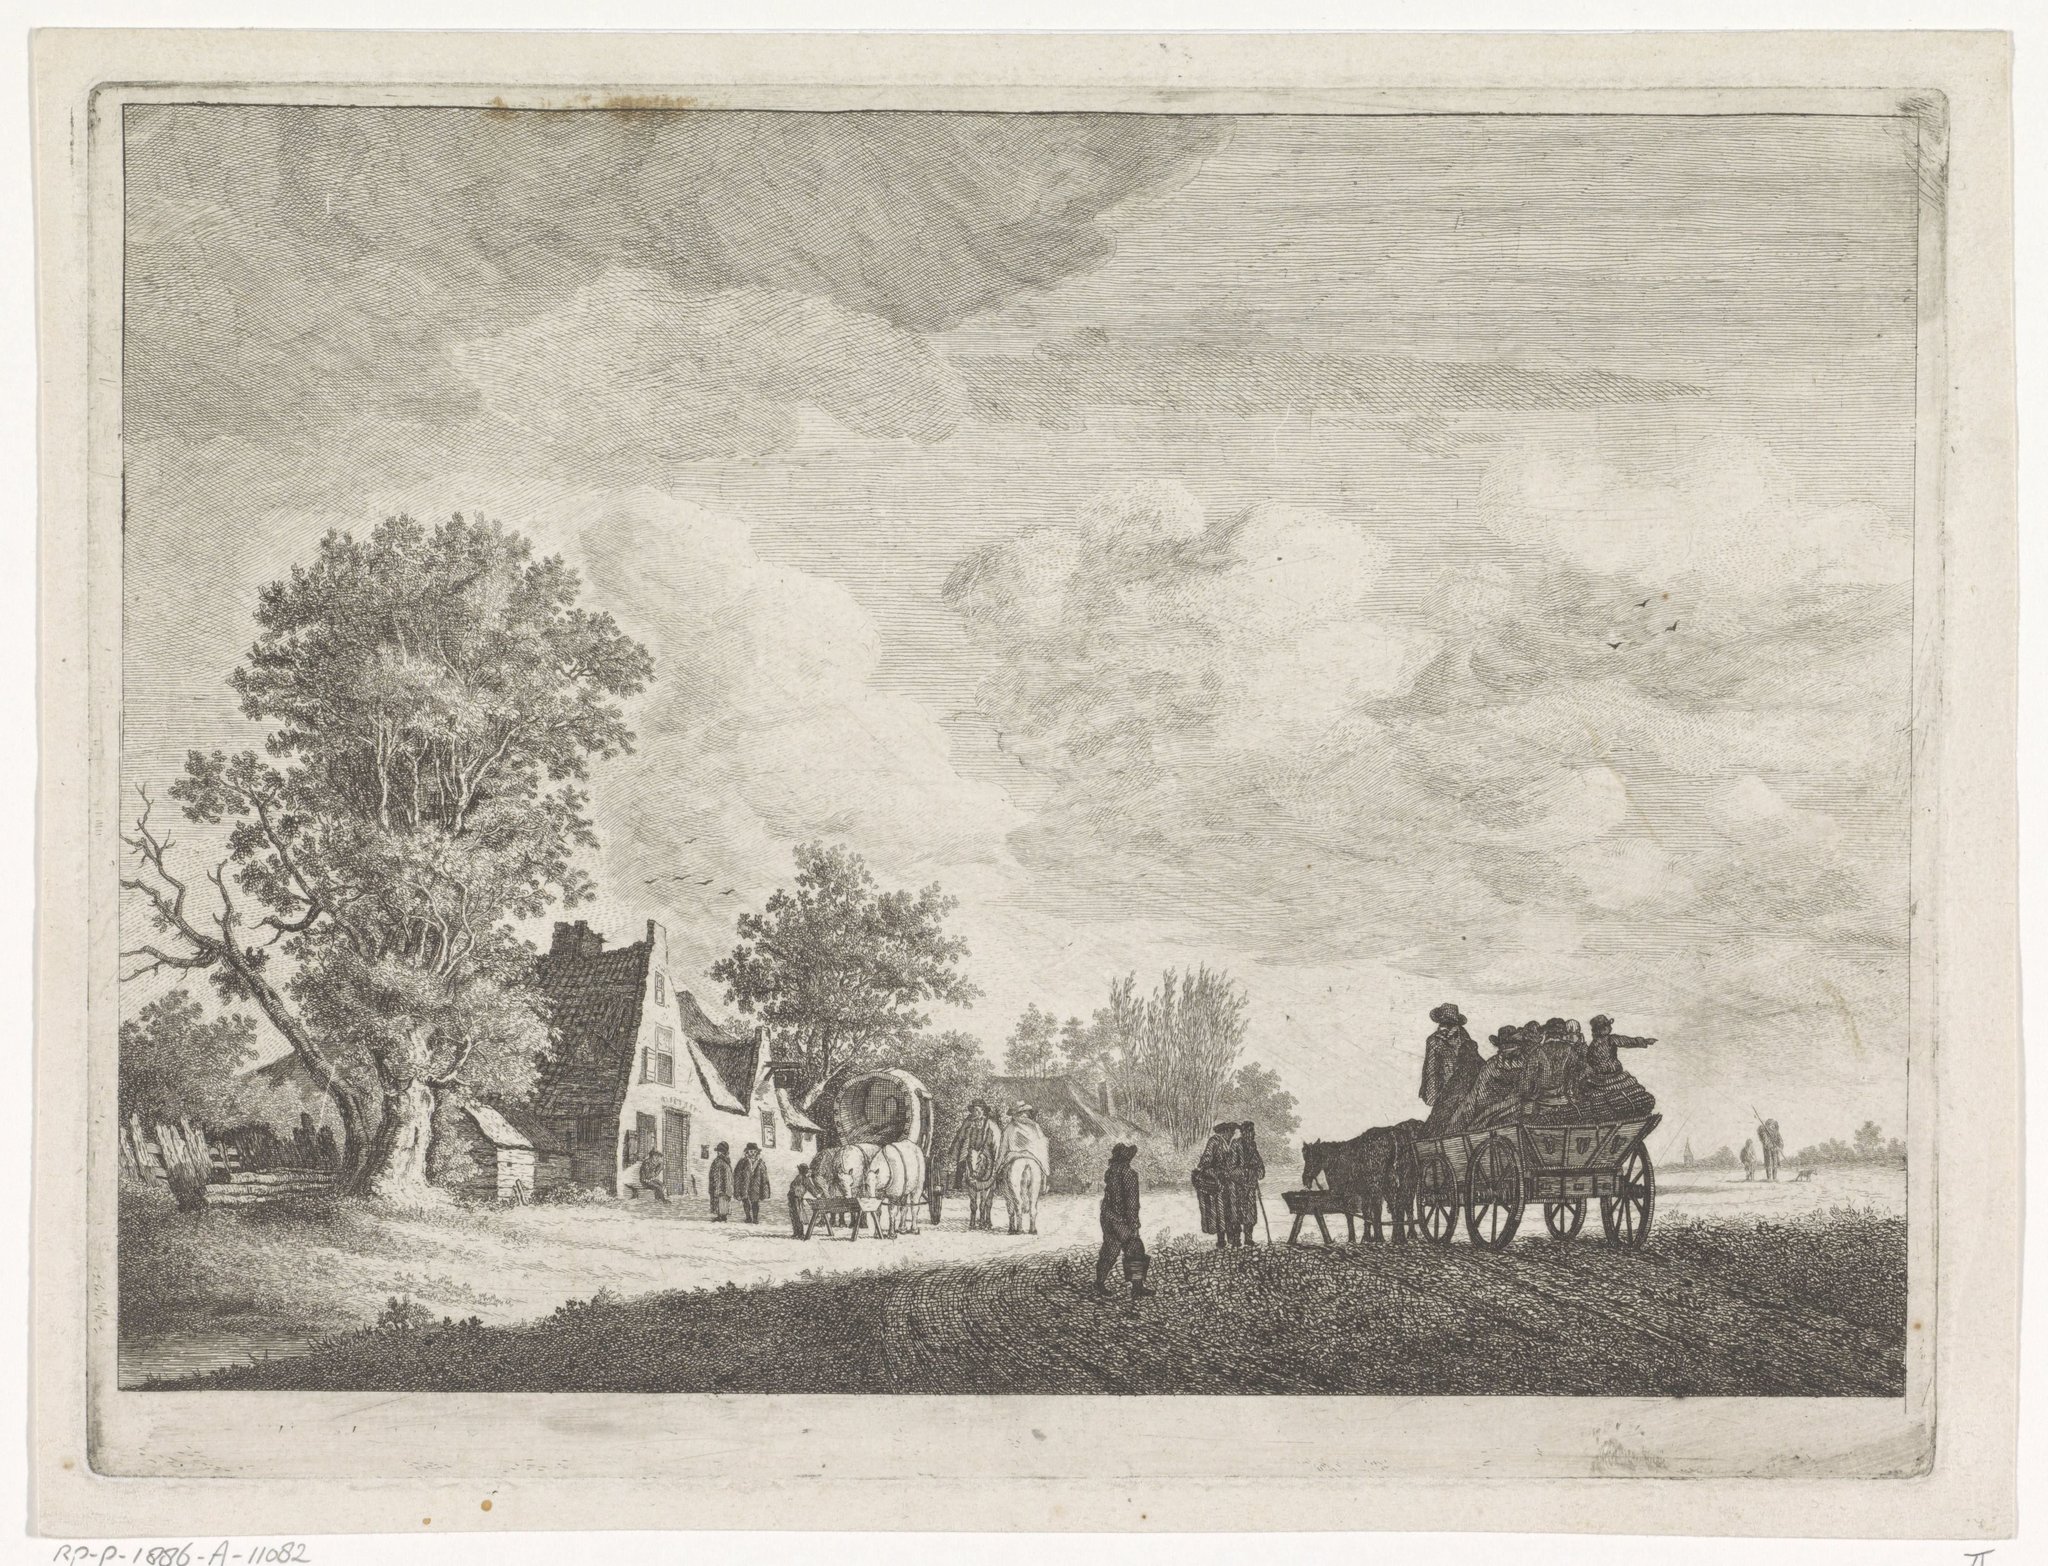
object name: print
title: Landschap met twee reiswagens voor een herberg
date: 1751-1799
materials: paper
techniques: etching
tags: four-wheeled, animal-drawn vehicle, e.g.: cab, carriage, coach, inn, coffee-house, public house, etc.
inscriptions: collector's mark: Lugt 2228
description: Halte bij een herberg. Bij een herberg rusten reizigers en paarden tijdens hun reis. Rechts een wagen met passsagiers. De paarden krijgen te drinken.